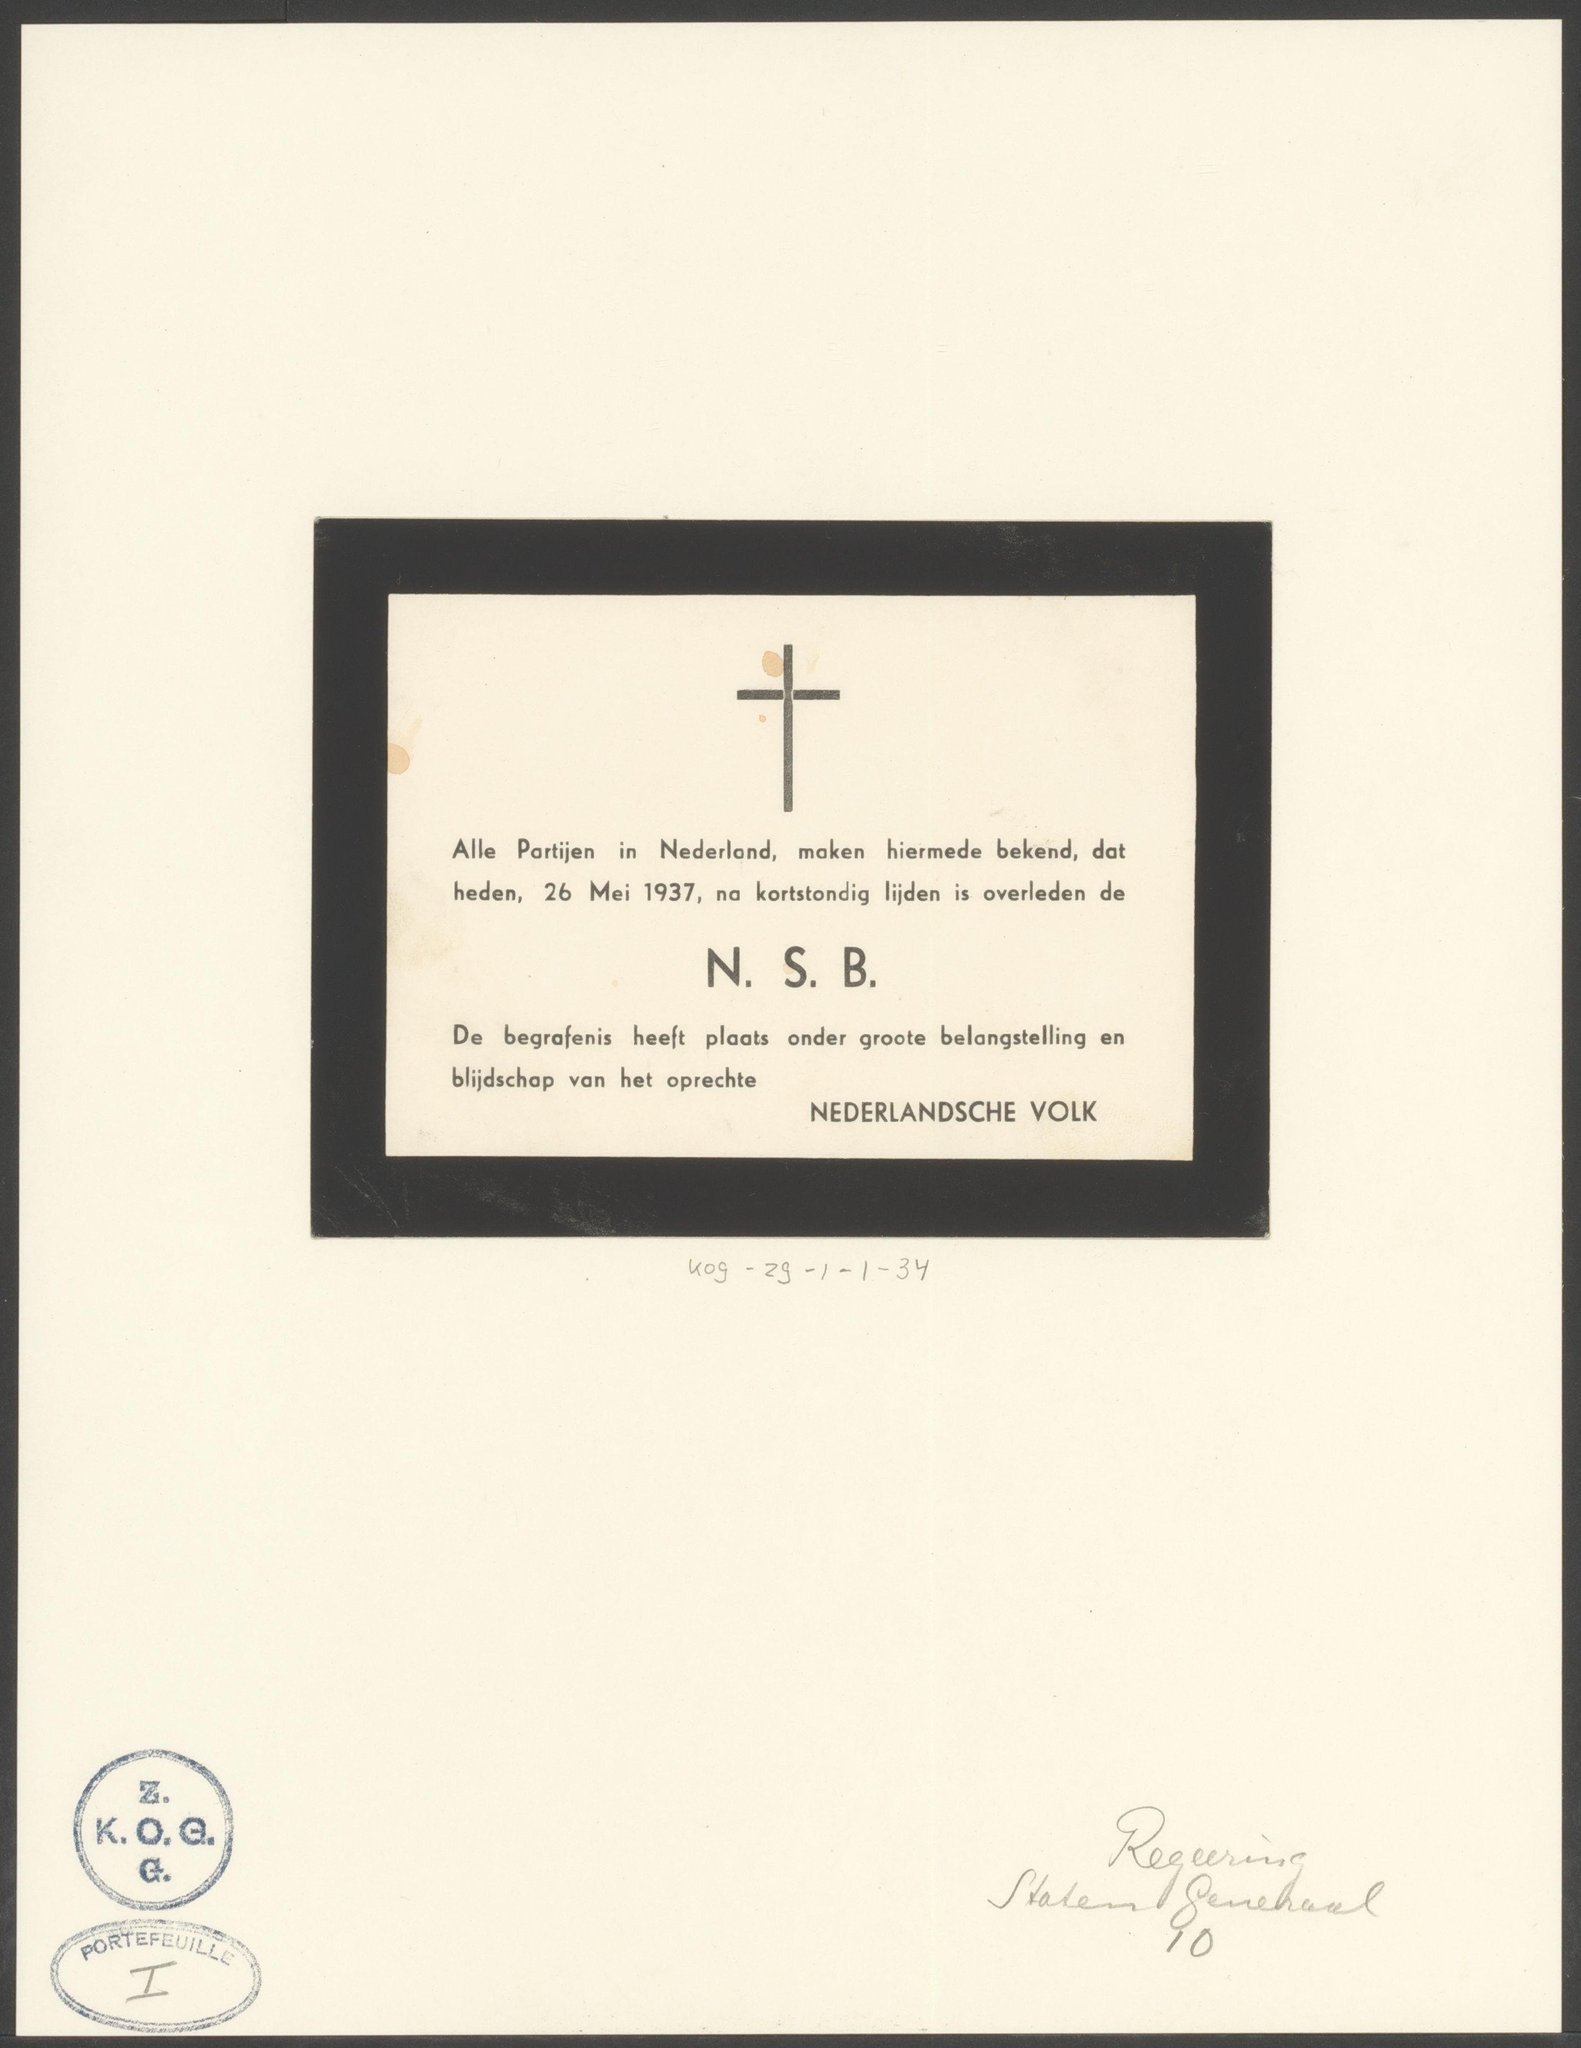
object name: overlijdensbericht, overlijdensadvertentie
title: Doodsaankondiging van de N.S.B.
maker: Anonymous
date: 1905-1937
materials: paper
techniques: printing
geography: netherlands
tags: voting, election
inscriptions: collector's mark, collector's mark: Lugt 1641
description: Satirische overlijdensbericht of doodsaankondiging gedrukt met dikke zwarte randen van de N.S.B., na de voor die partij teleurstellende resultaten in de verkiezingen 26 mei 1937. Onderwerpsrubrieken binnen de Atlas Zeden en Gewoonten: Regeering, Staten-Generaal.